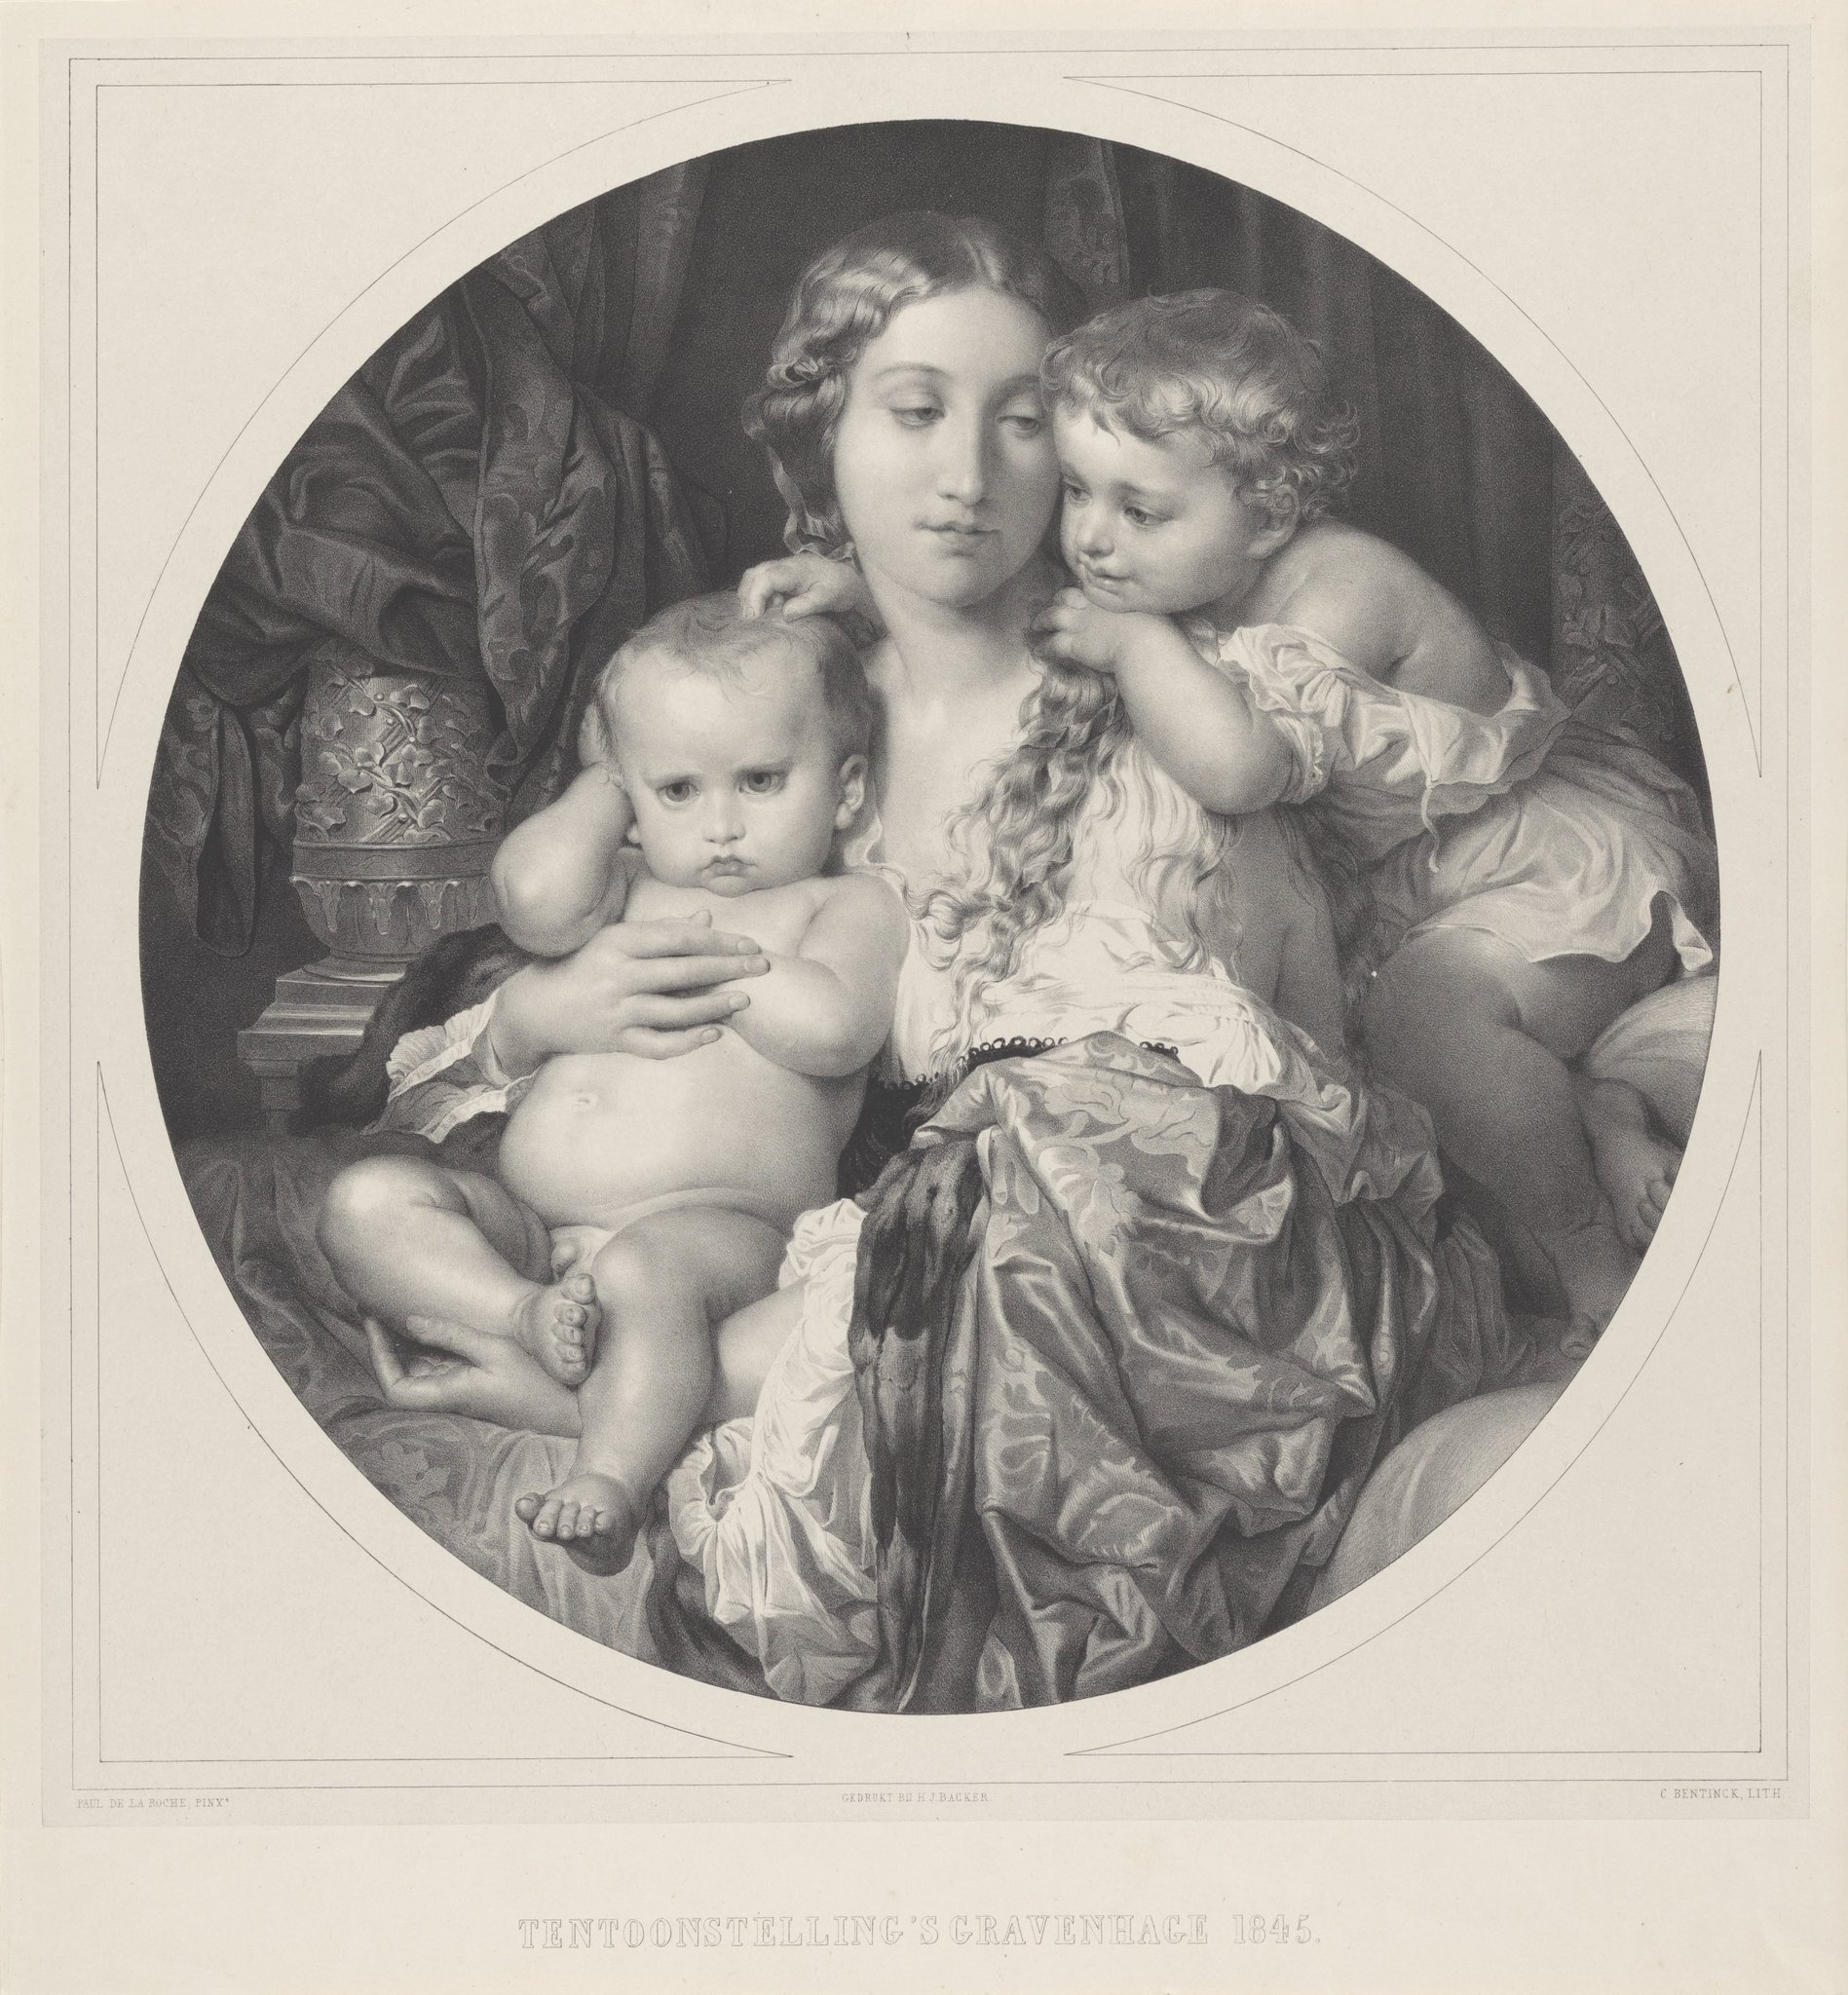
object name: print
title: Tentoonstelling 's Gravenhage 1845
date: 1845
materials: paper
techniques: lithograph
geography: netherlands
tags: mother and baby or young child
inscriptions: collector's mark: Lugt 2228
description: De vrouw zit te midden van twee kinderen. Een kind zit naakt bij haar op schoot, het andere kind leunt over haar schouder. Achter hen draperieën. Mogelijk Maria, Jezus en Johannes de Doper.